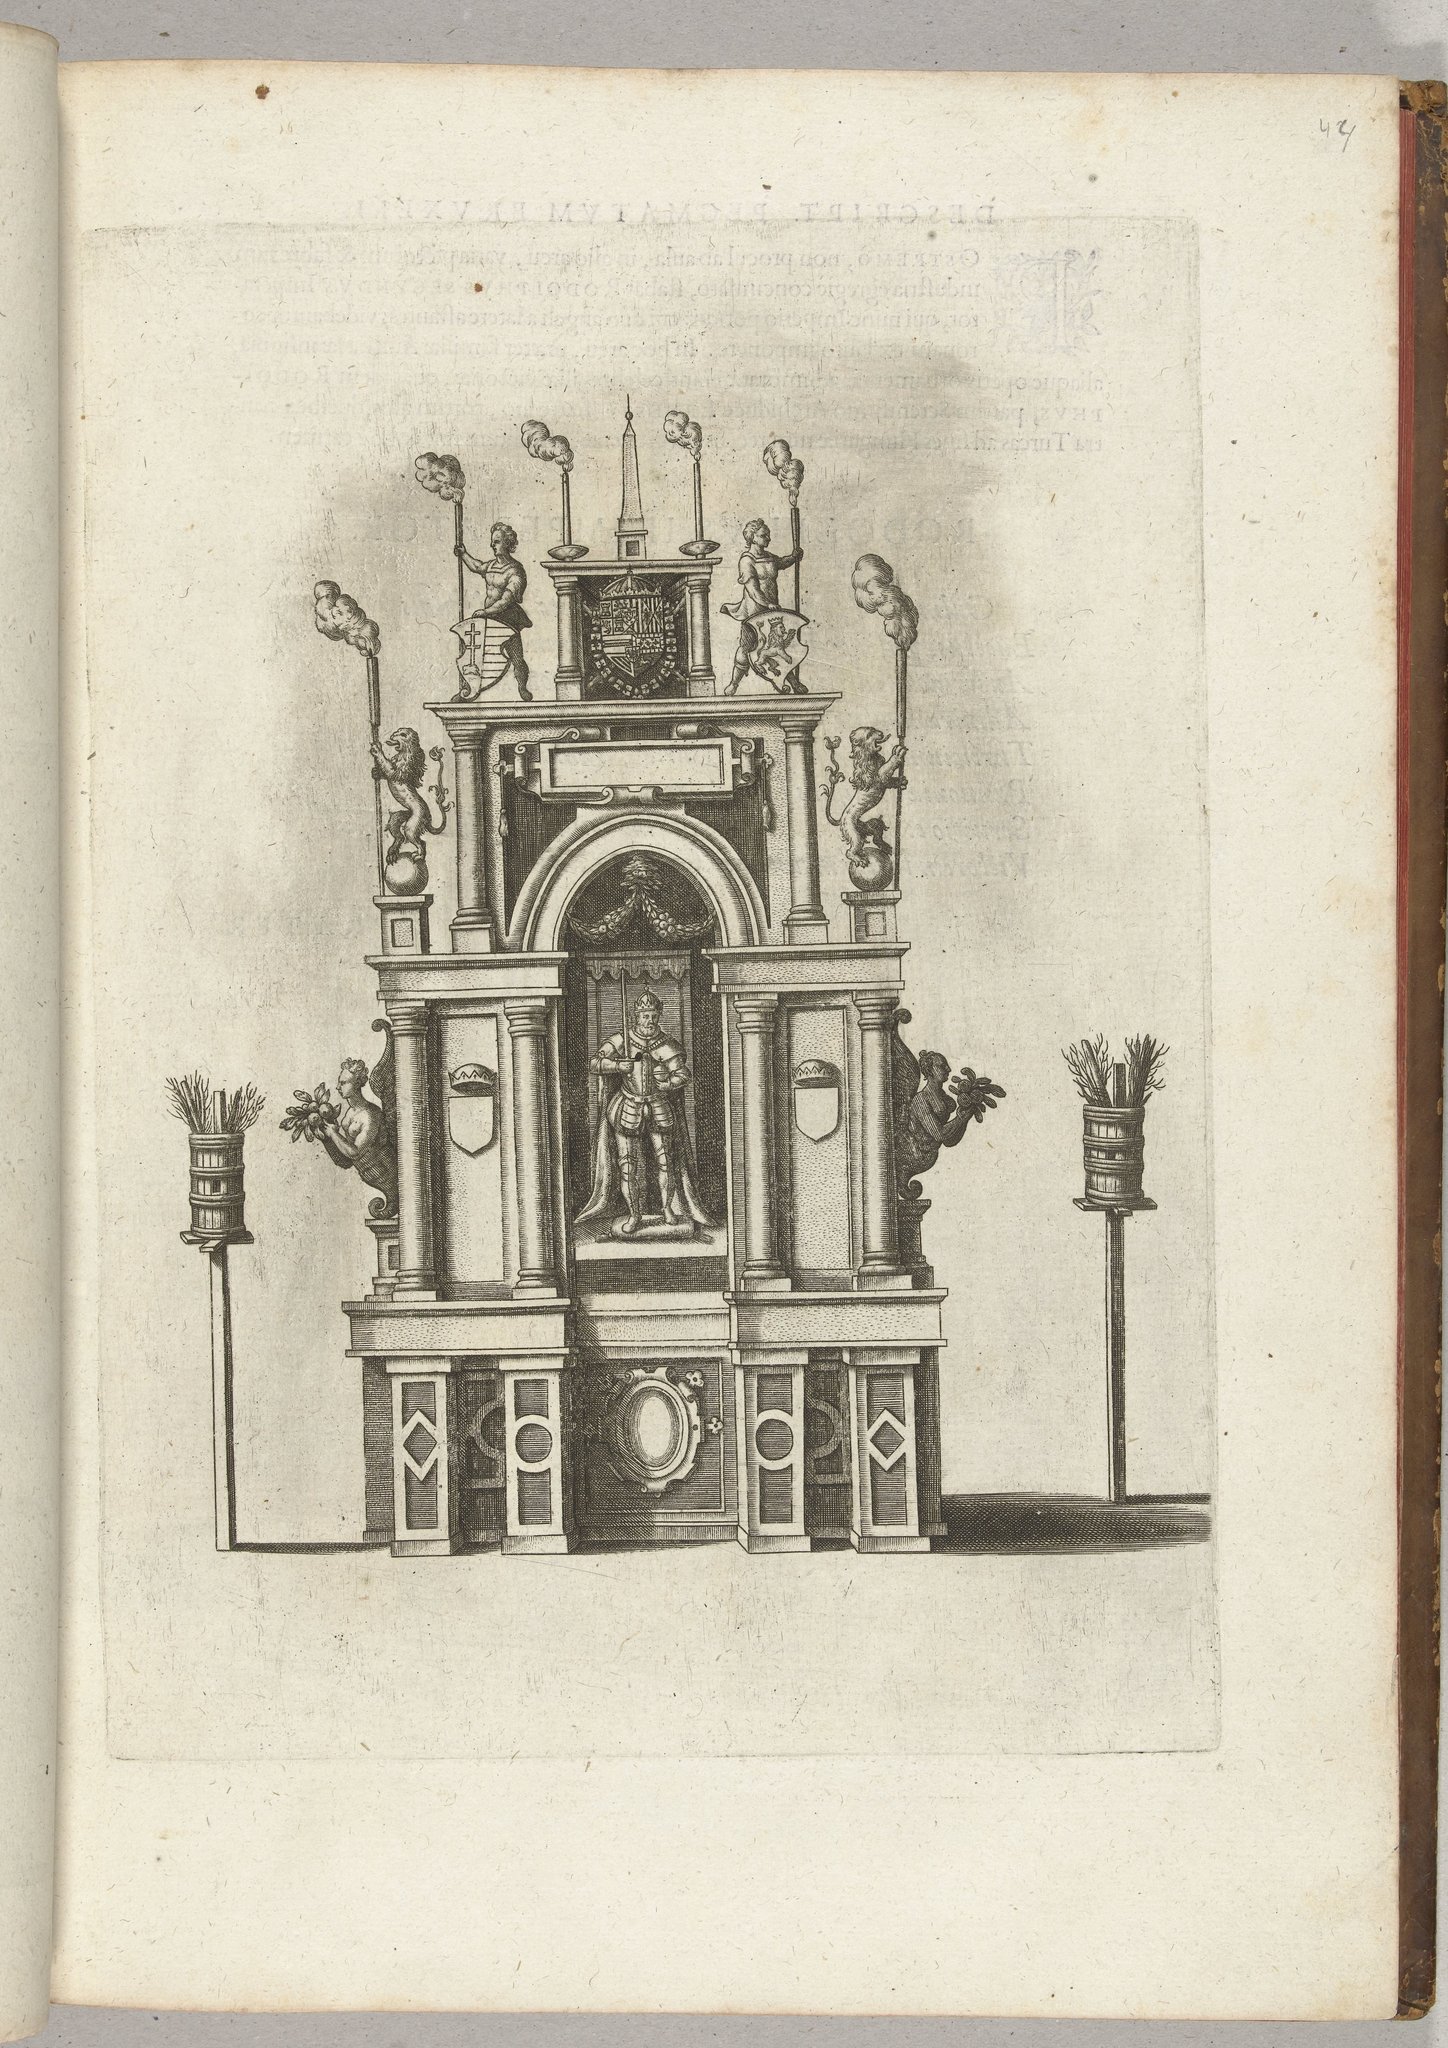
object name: print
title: Toneel met keizer Maximiliaan II, 1594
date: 1594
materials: paper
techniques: engraving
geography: brussels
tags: brussels, vienna, maximiliaan ii (keizer van heilige roomse rijk), triumphal entry and public reception, pageant, 'entrée solennelle', 'joyeuse entrée'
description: Illustratie in: Descriptio et explicatio pegmatvm, arcvvm et spectacvlorvm qvae Brvxellae Brabant : pridie cal: Febr. Ao 1594 exhibita fvere, svb ingressvm Sereniss : Principis Ernesti, Dei Gratia Archidvcis Avstriae ... pro Philippo II. Hispaniarvm Monarcha, Belgicae ditionis Gvbernatore, Johannes Mommaert, Brussel 1594, [plaat 18]. In de collectie van de Rijksmuseum Research Library, signatuur: 325 A 9. Niet in Frederik Muller; door het RPK toegevoegd nummer.